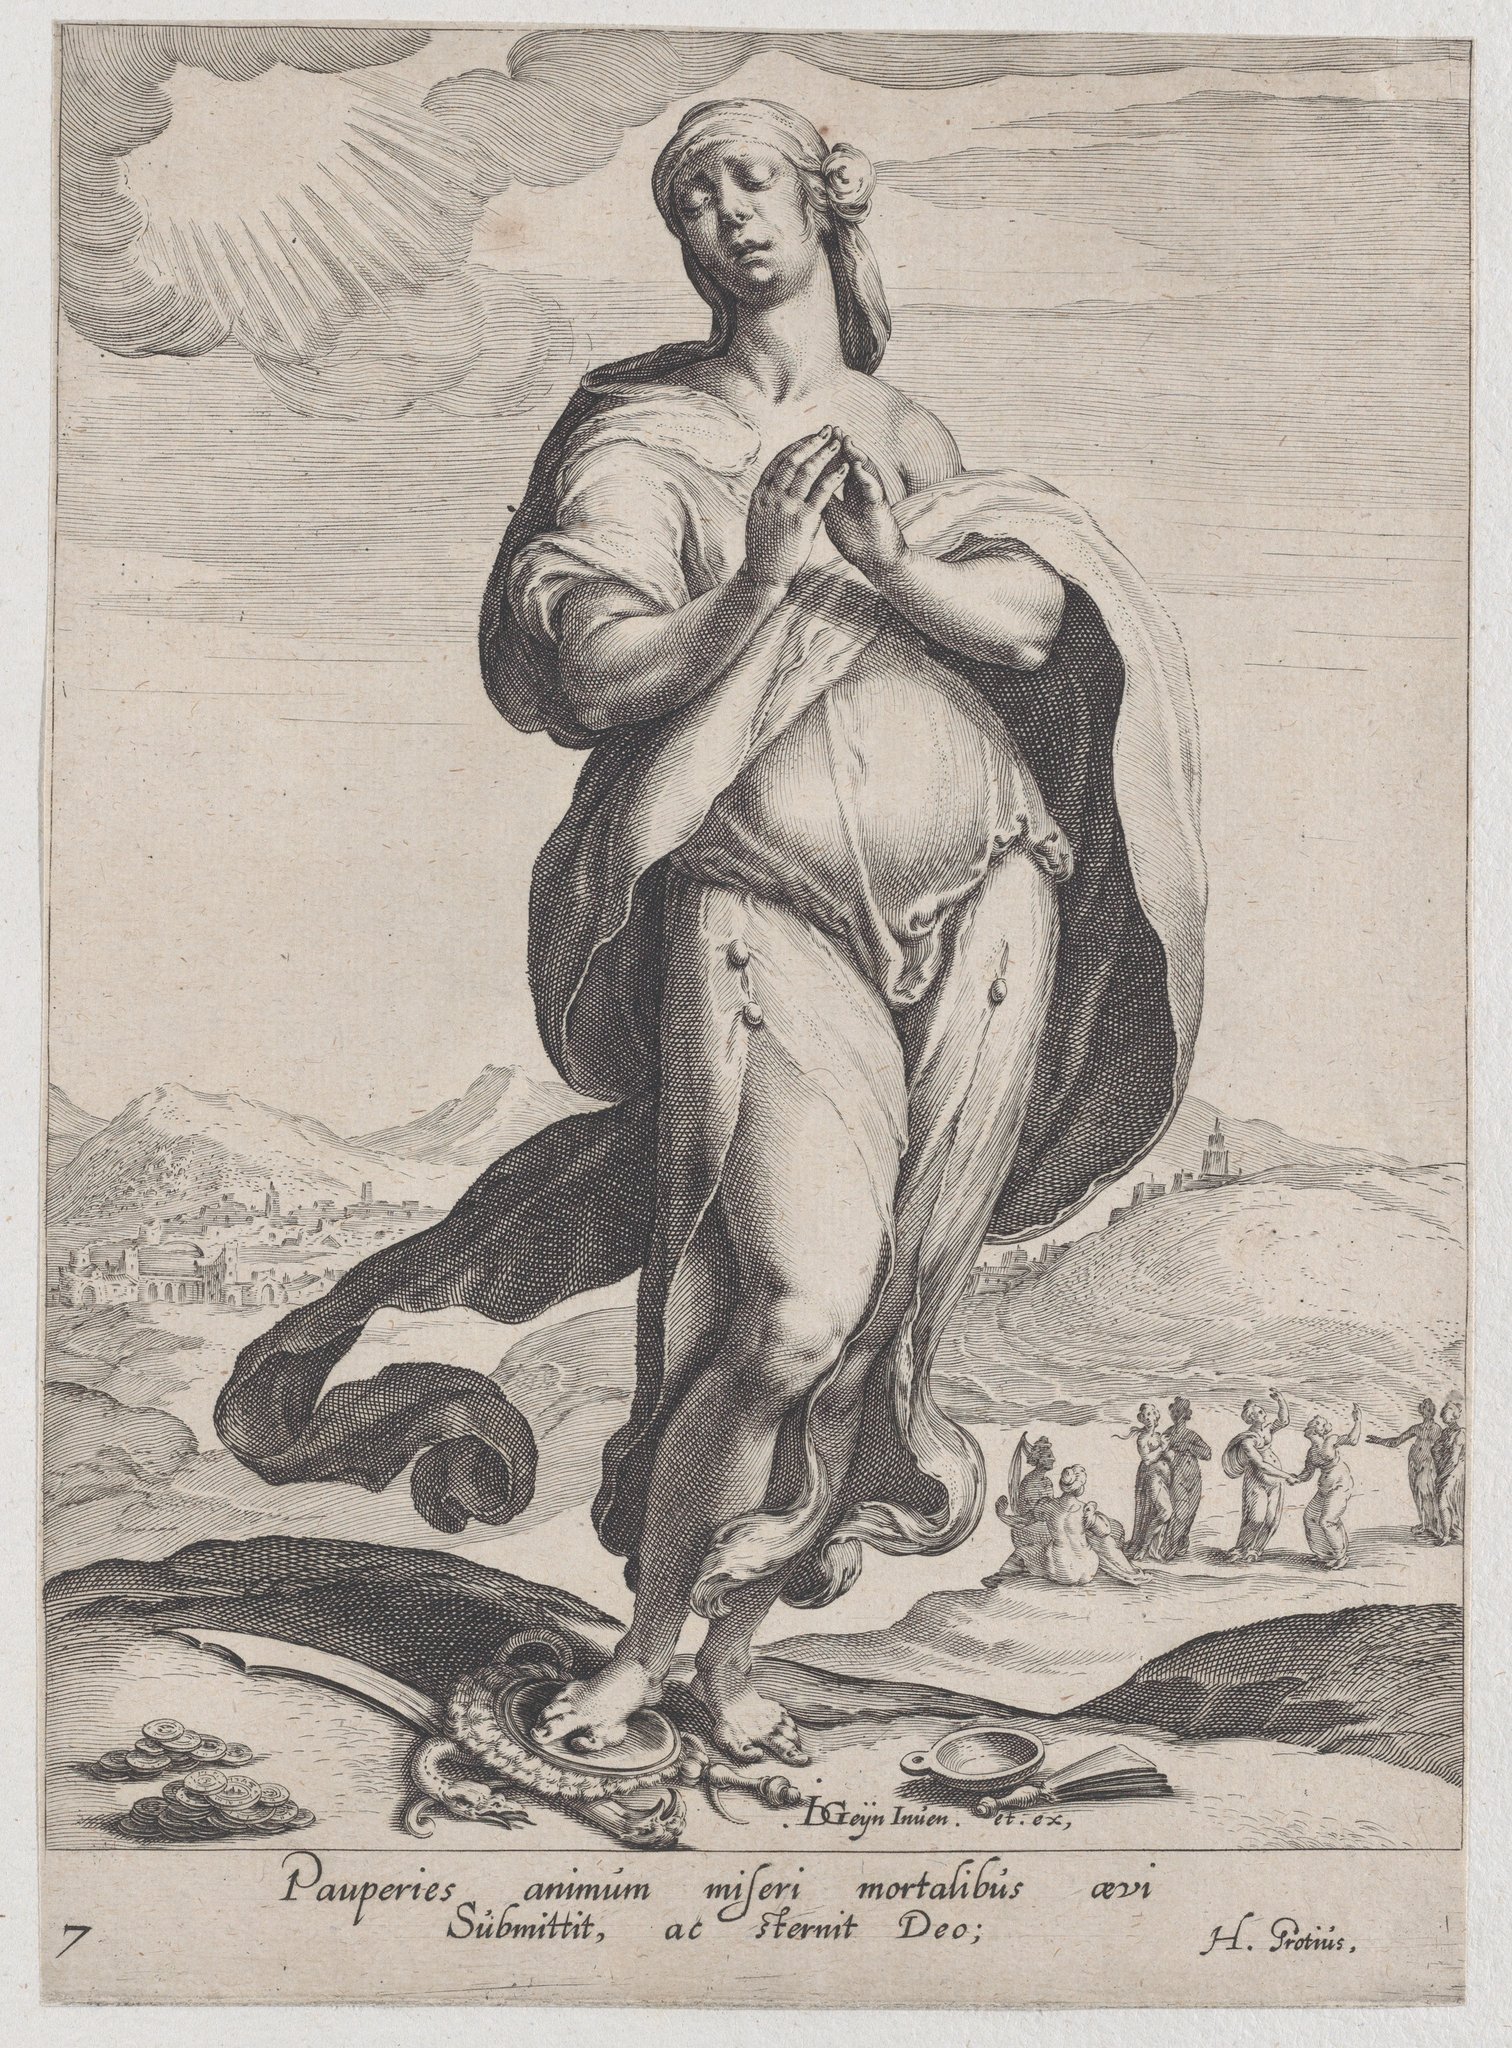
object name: print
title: Faith, from "Virtues and Vices"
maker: zacharias dolendo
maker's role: artist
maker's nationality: netherlandish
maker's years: 1561-1604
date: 1596-1597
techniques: engraving